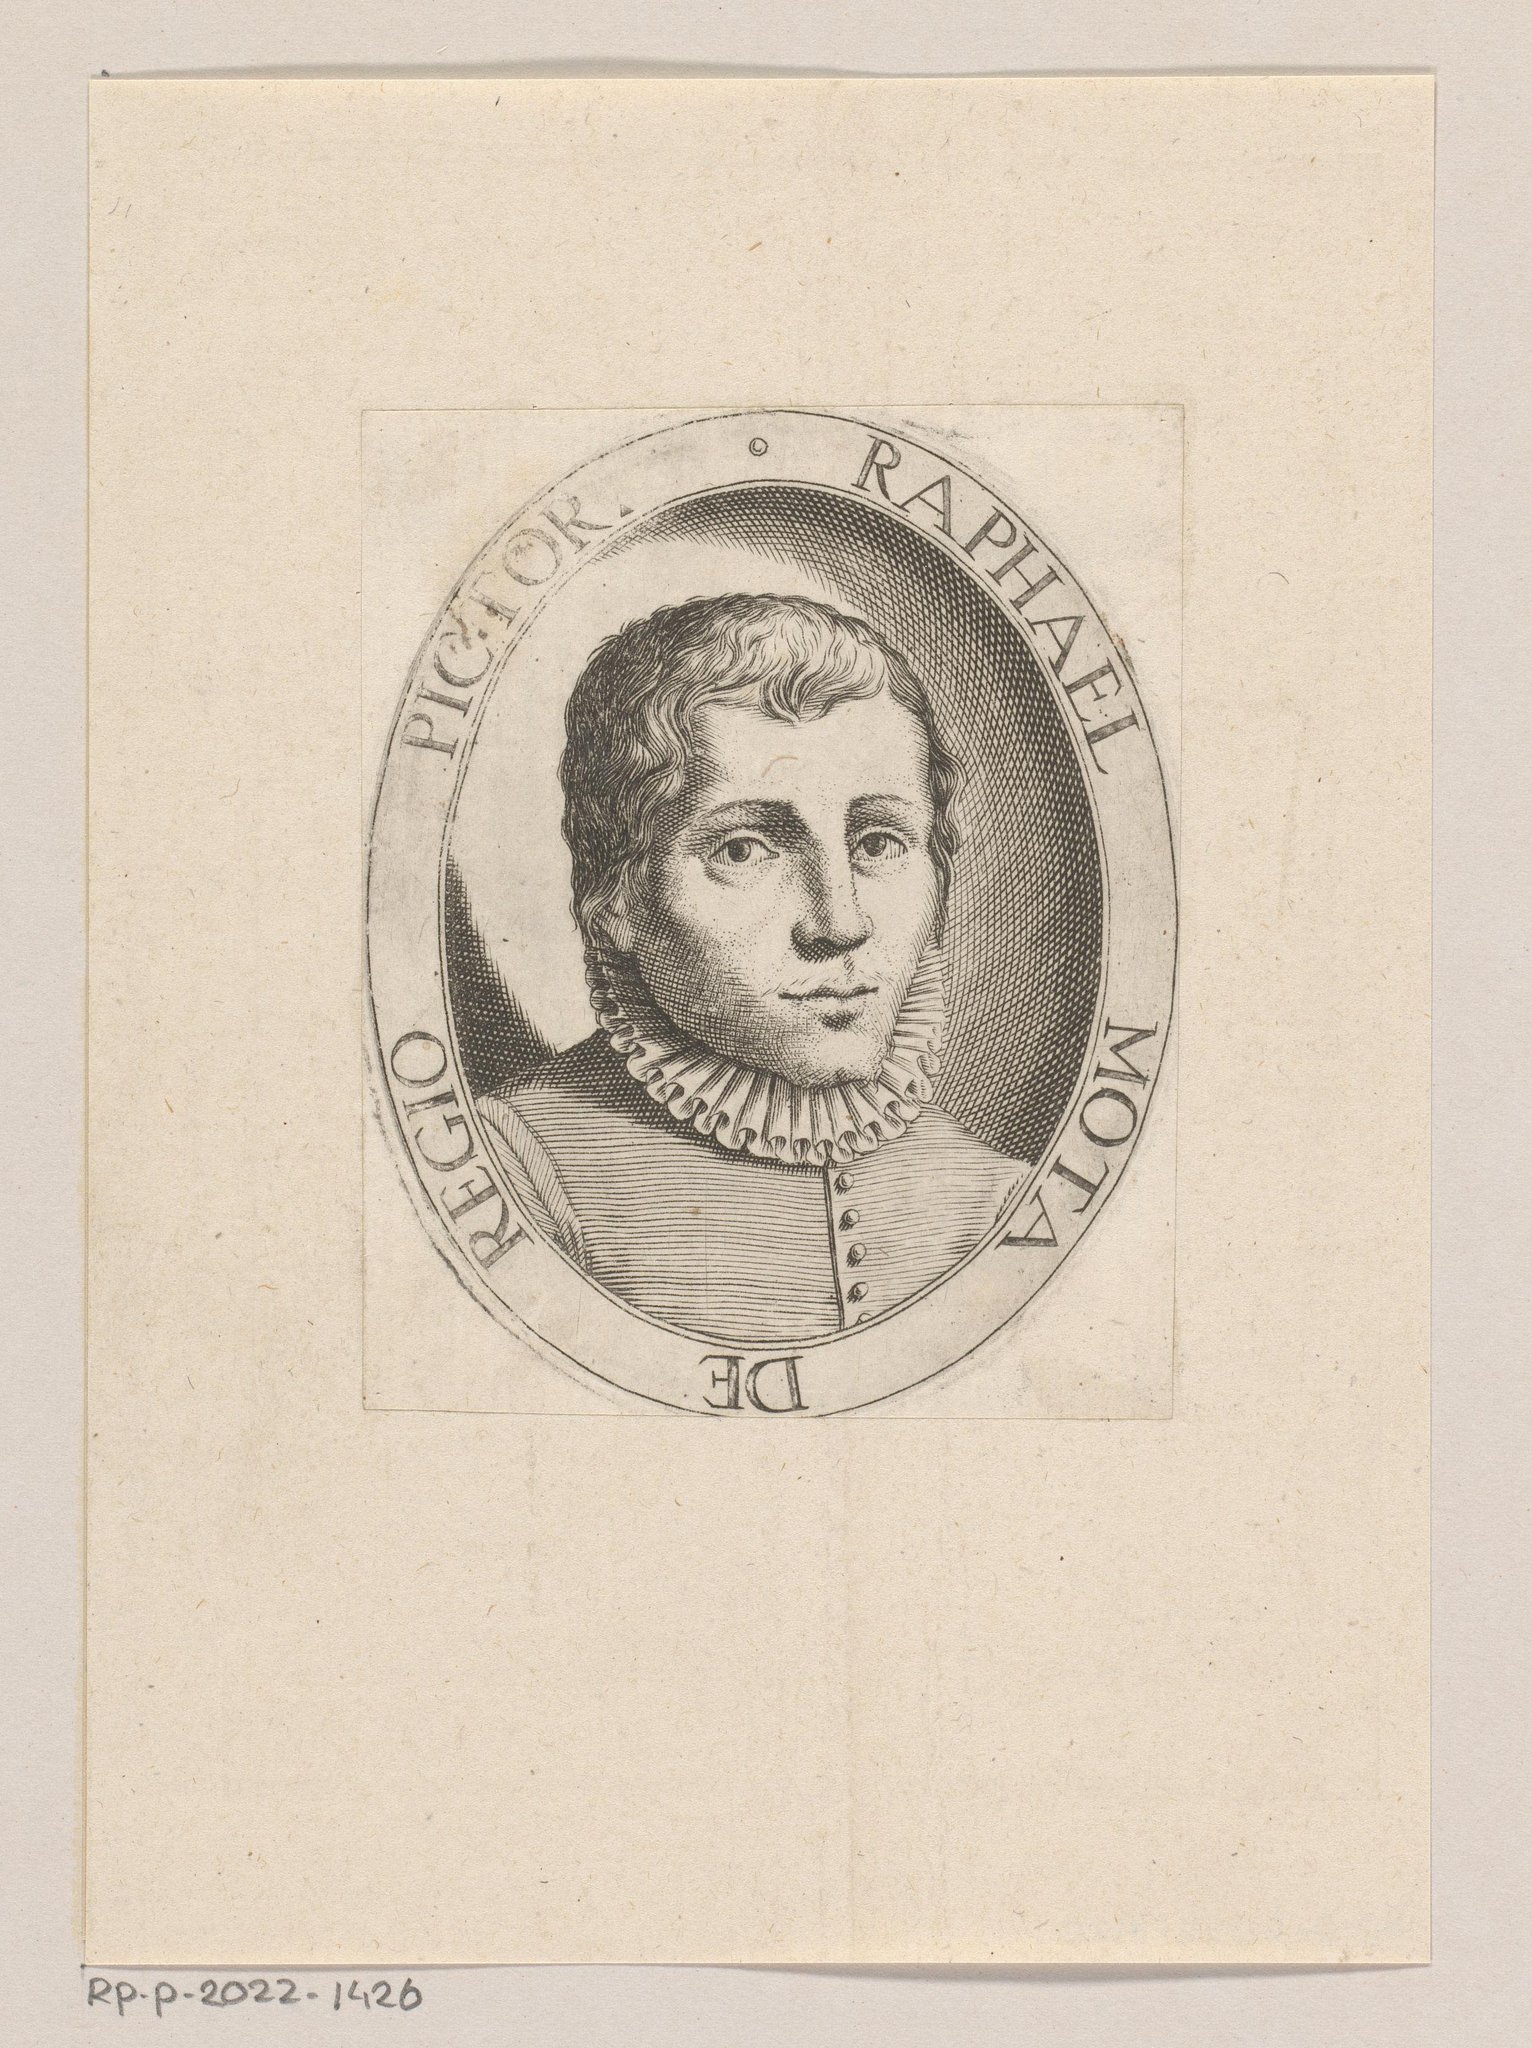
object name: print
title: Portret van Raffaellino da Reggio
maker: Anonymous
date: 1572-1700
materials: paper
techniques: engraving, snipping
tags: raffaellino da reggio, historical persons, portrait, self-portrait of painter